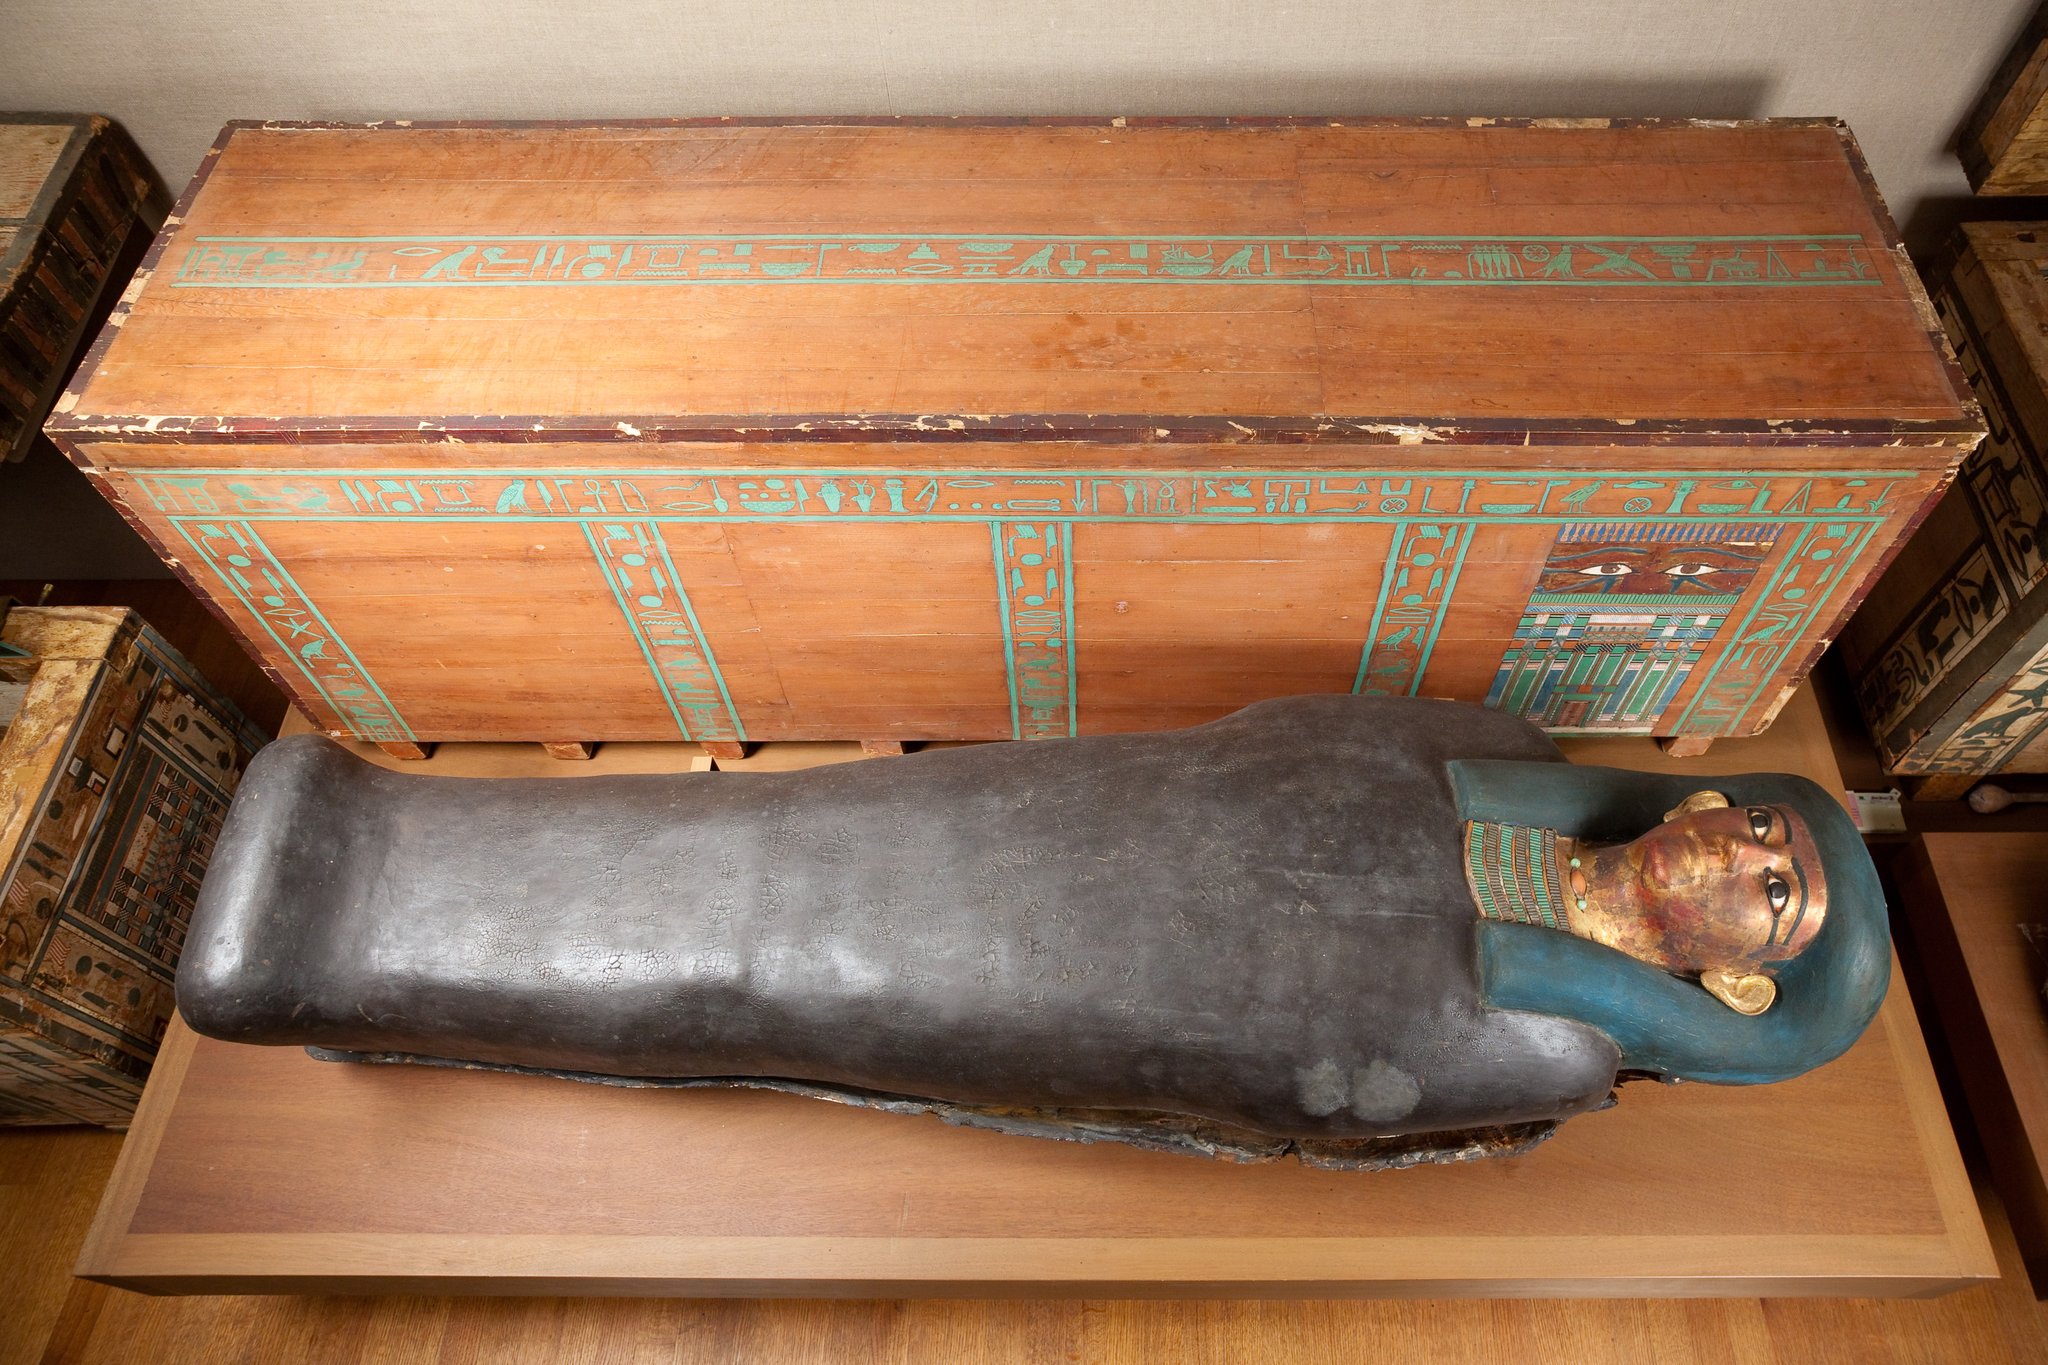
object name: coffin, outer, nephthys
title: Outer Coffin of Nephthys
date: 1961-1878 BCE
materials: gold leaf, wood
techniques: painting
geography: egypt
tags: coffins